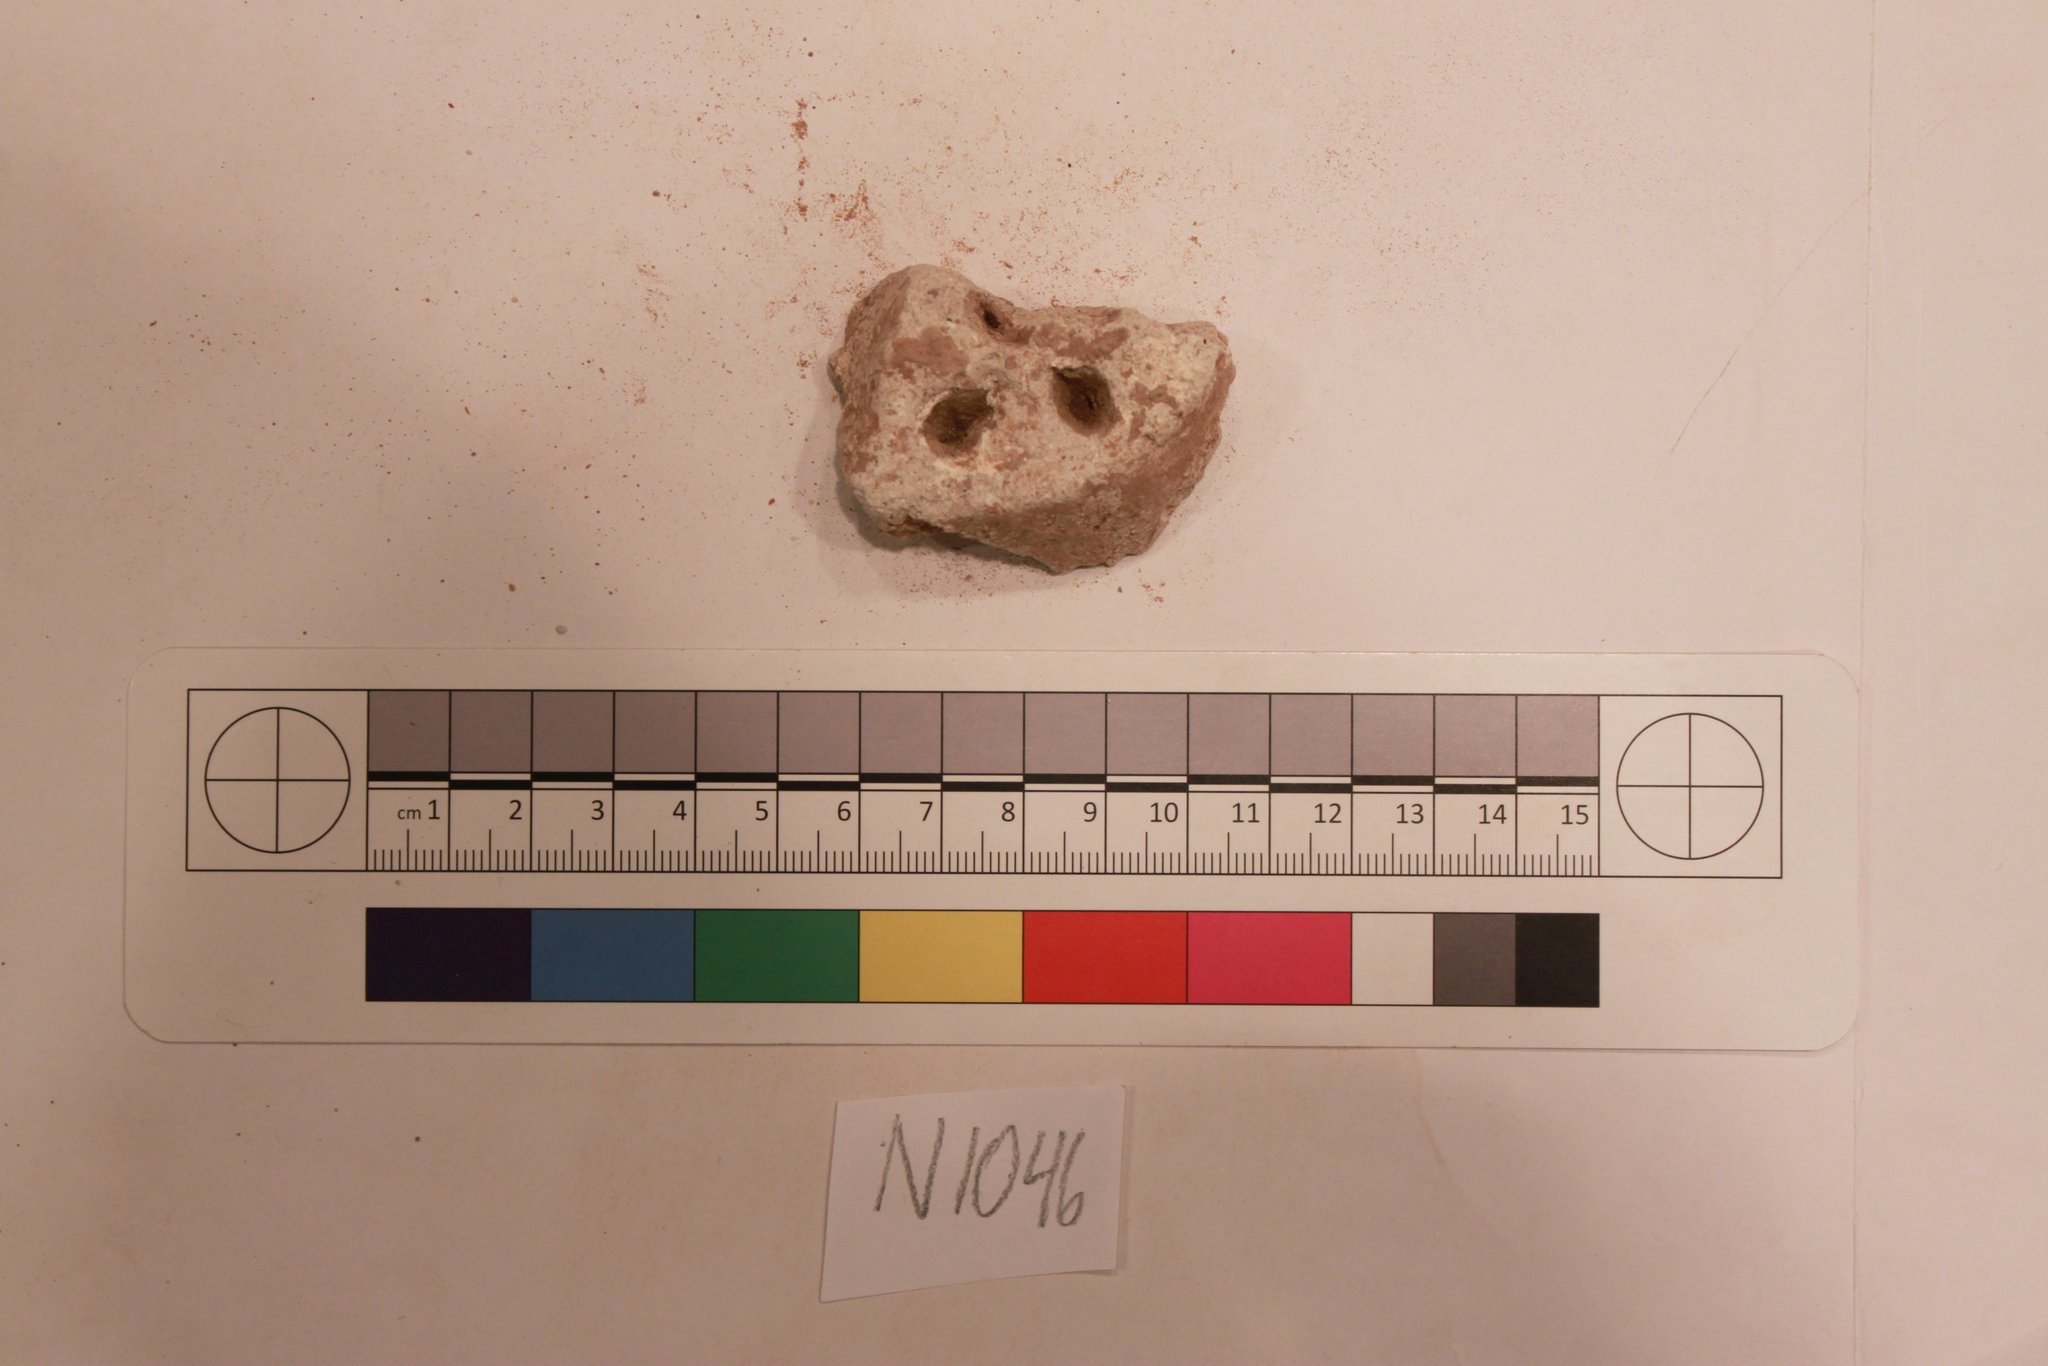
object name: fragment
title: Stucco Fragment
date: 701-1200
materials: plaster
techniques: carving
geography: iran